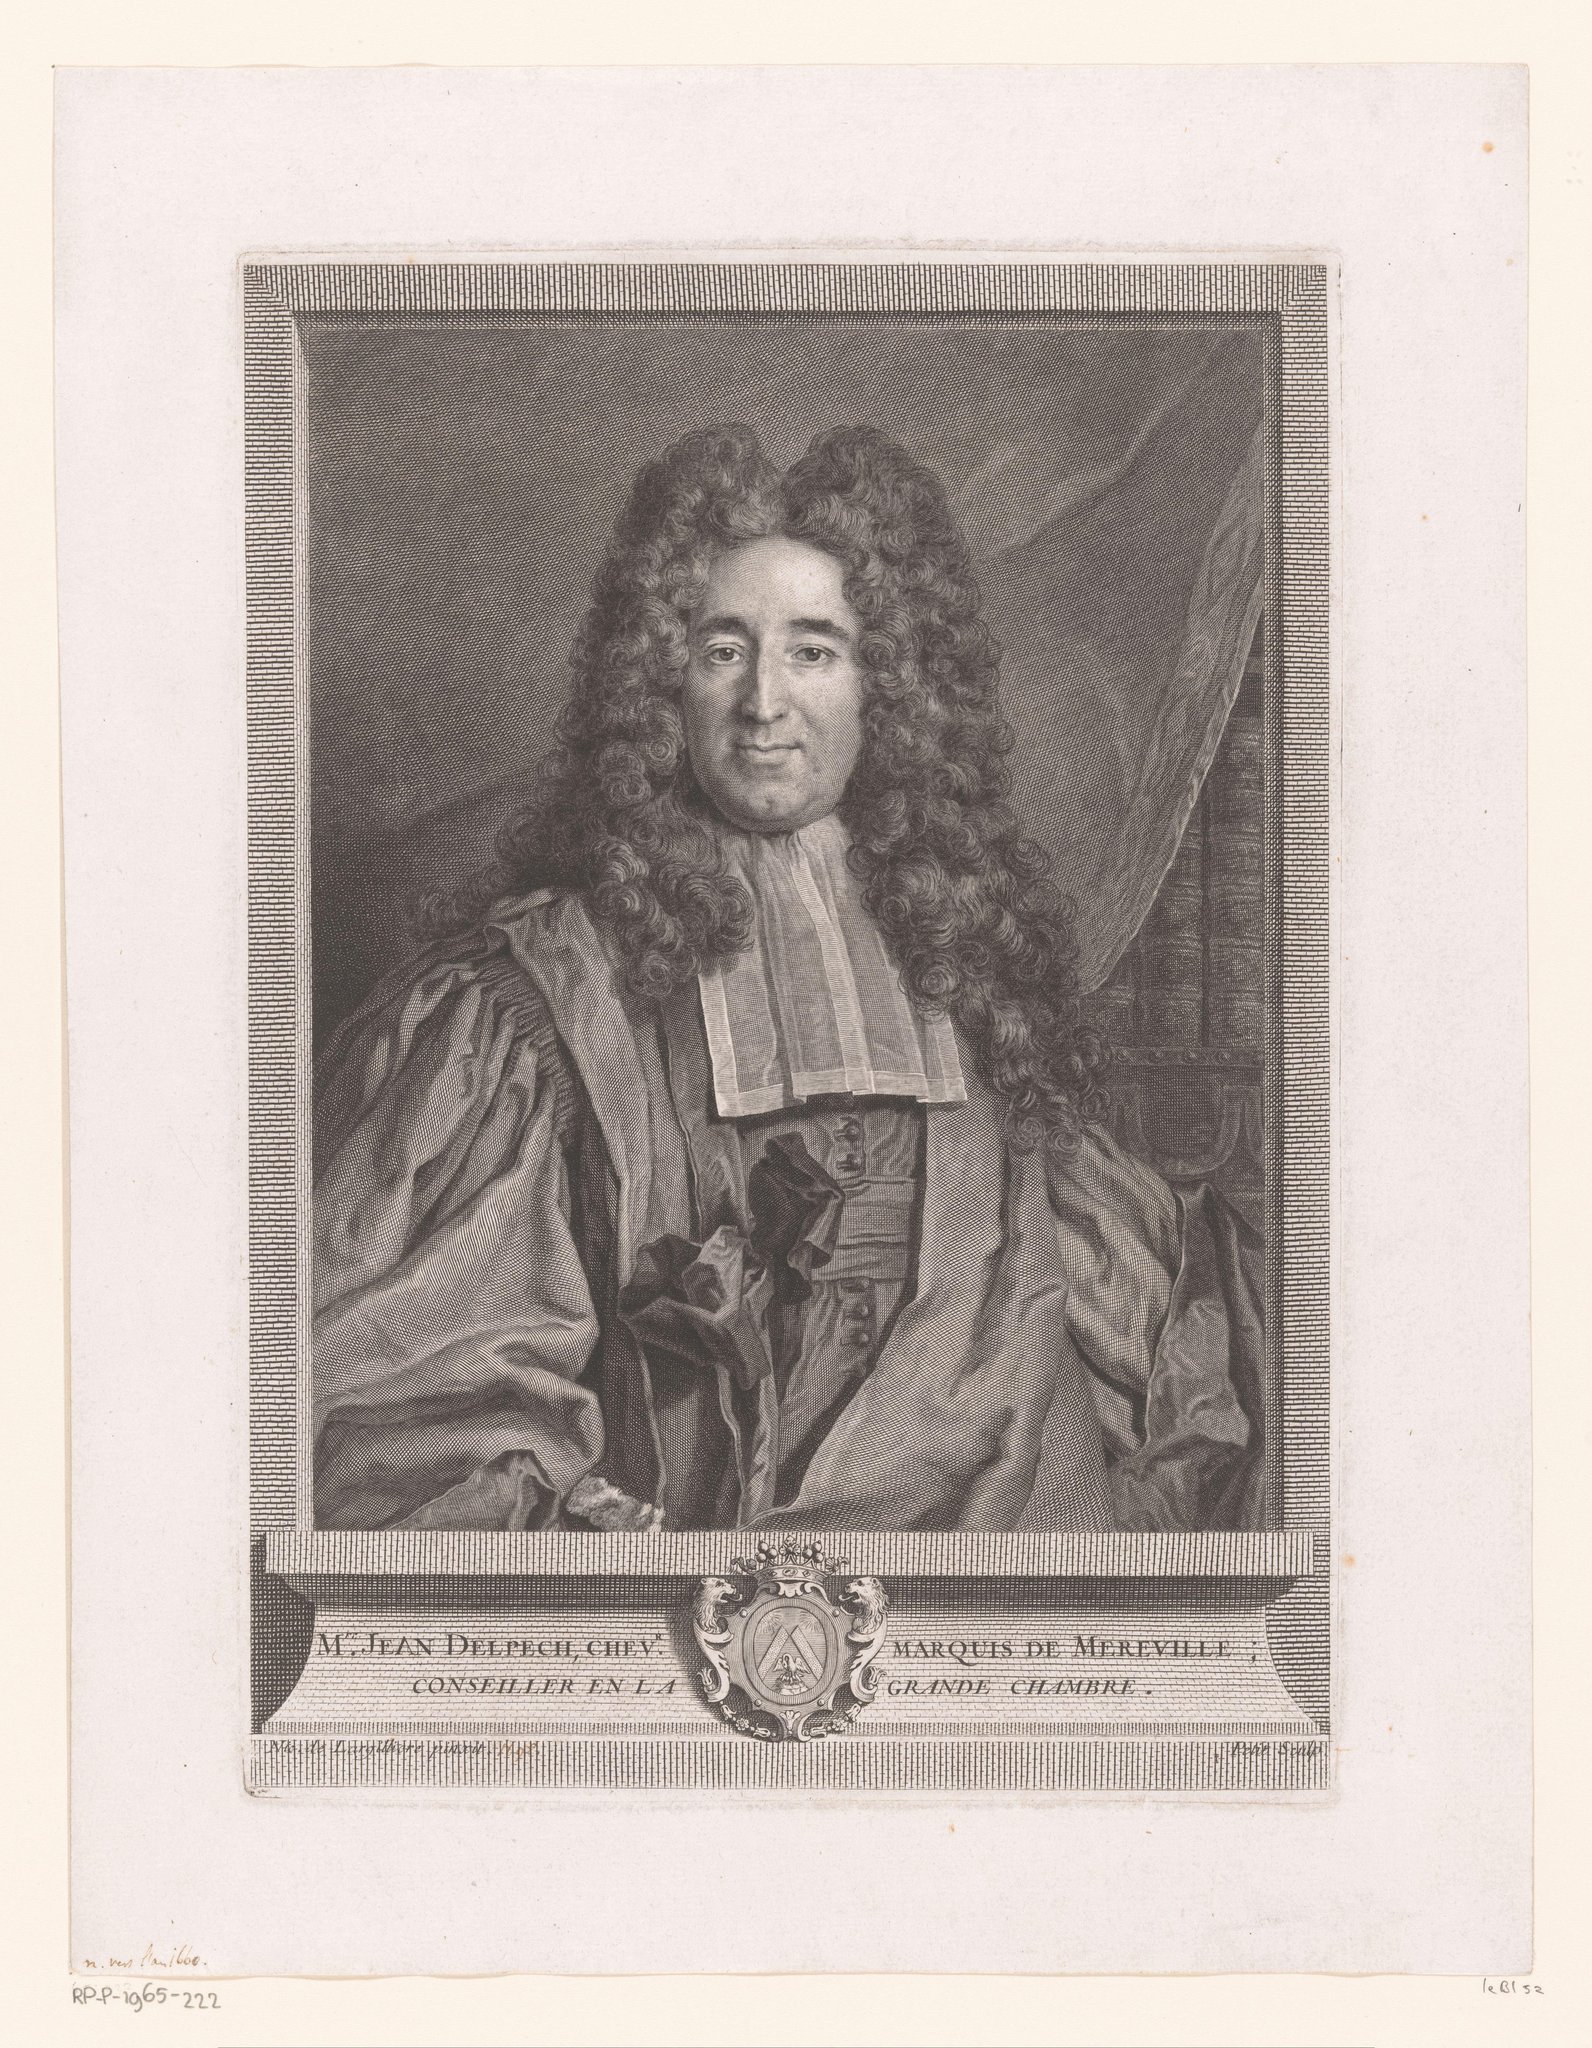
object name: print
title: Portret van Jean Delpech de Méréville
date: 1734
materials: paper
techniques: engraving, etching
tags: official; civil servant; functionary (in general), historical persons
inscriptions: collector's mark: Lugt 2228, collector's mark: Lugt 2760